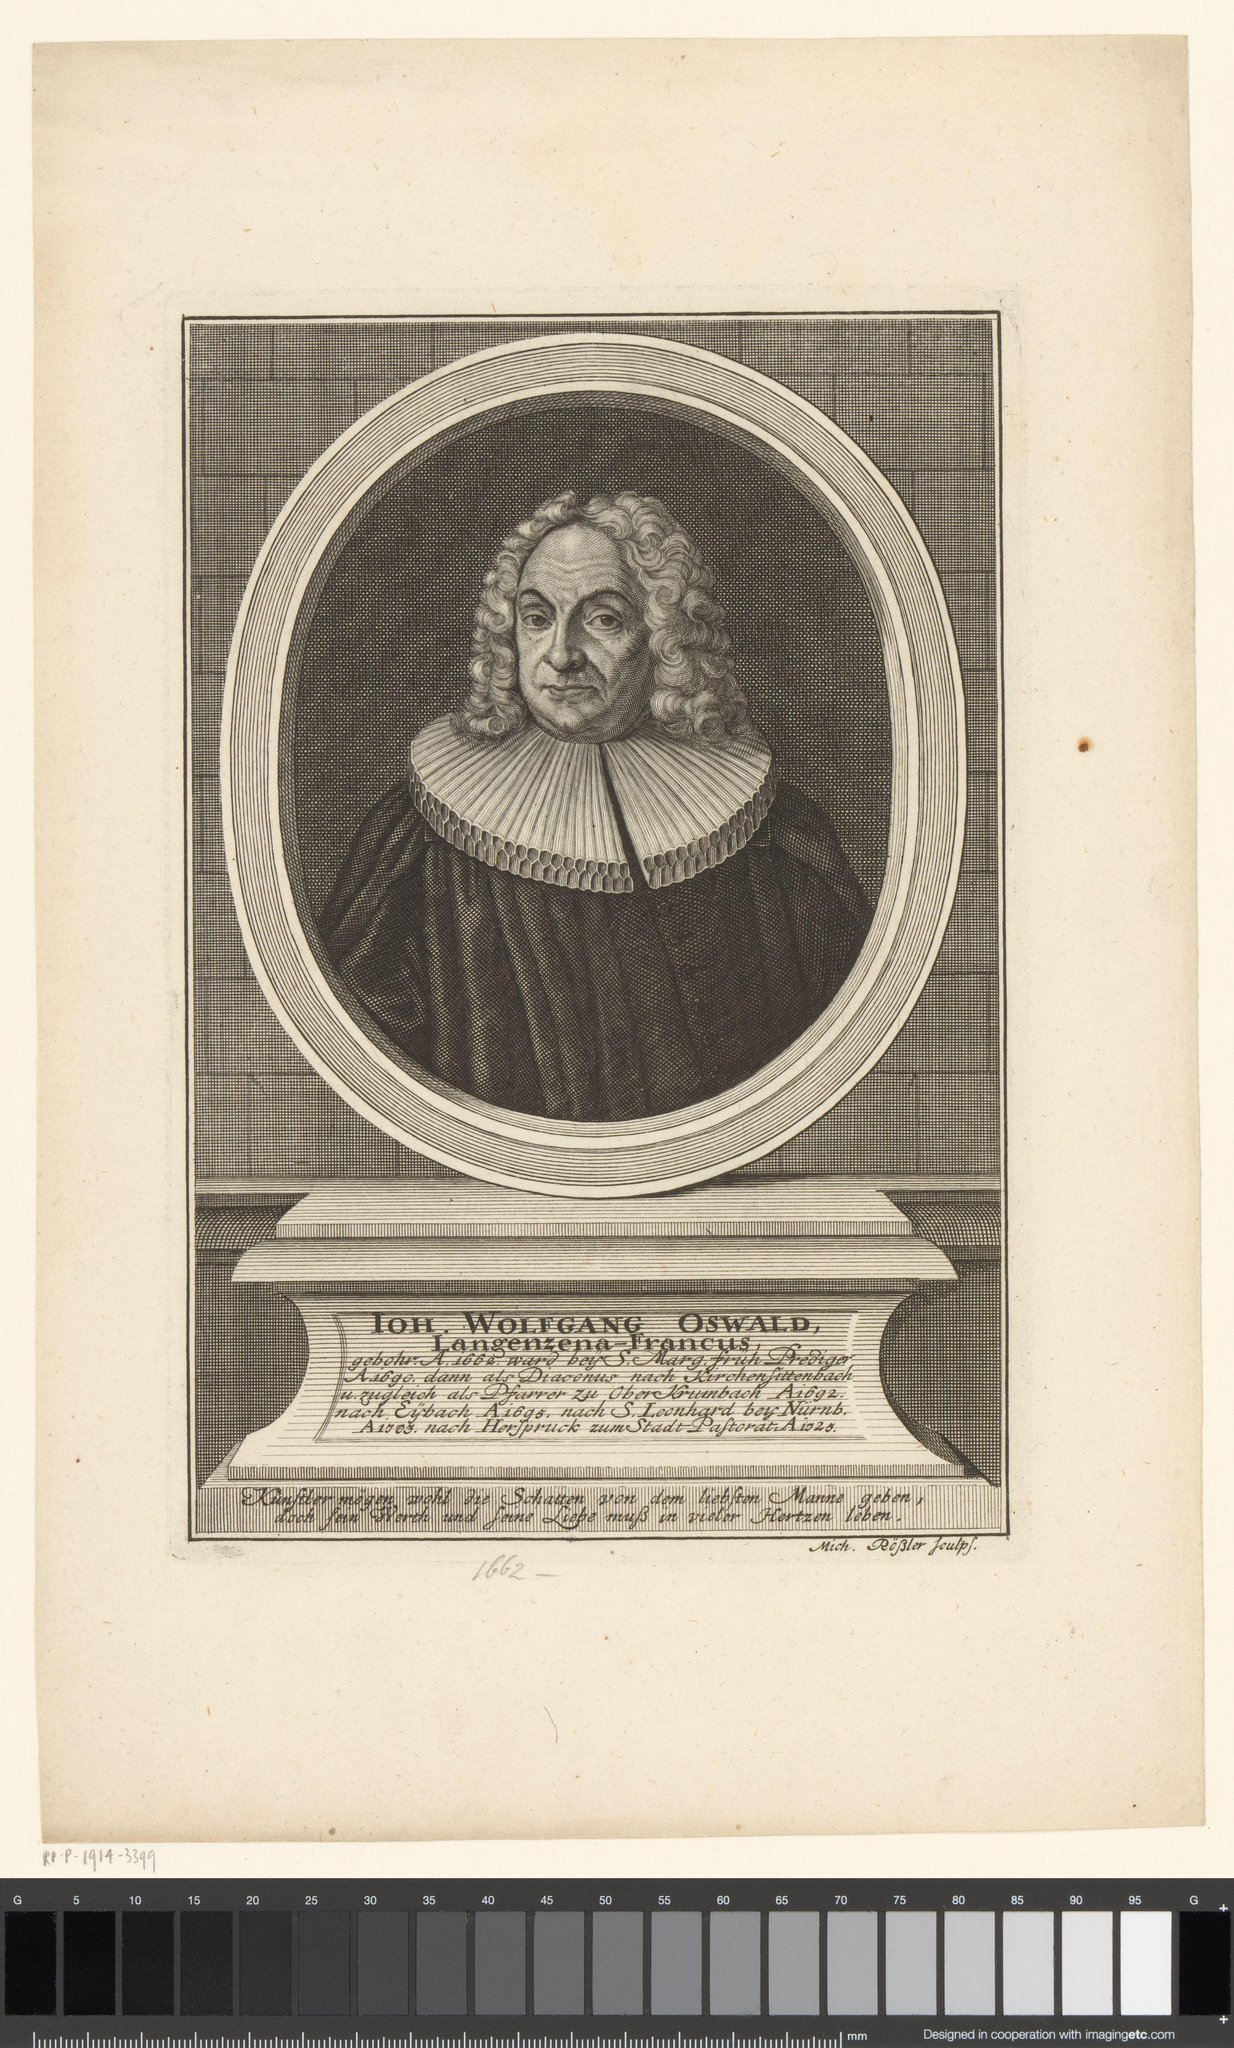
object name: print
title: Portret van Johann Wolfgang Osswald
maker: michael rössler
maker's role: print maker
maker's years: 1705-1777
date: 1715-1777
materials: paper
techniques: engraving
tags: theologian, historical persons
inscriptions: collector's mark: Lugt 2228